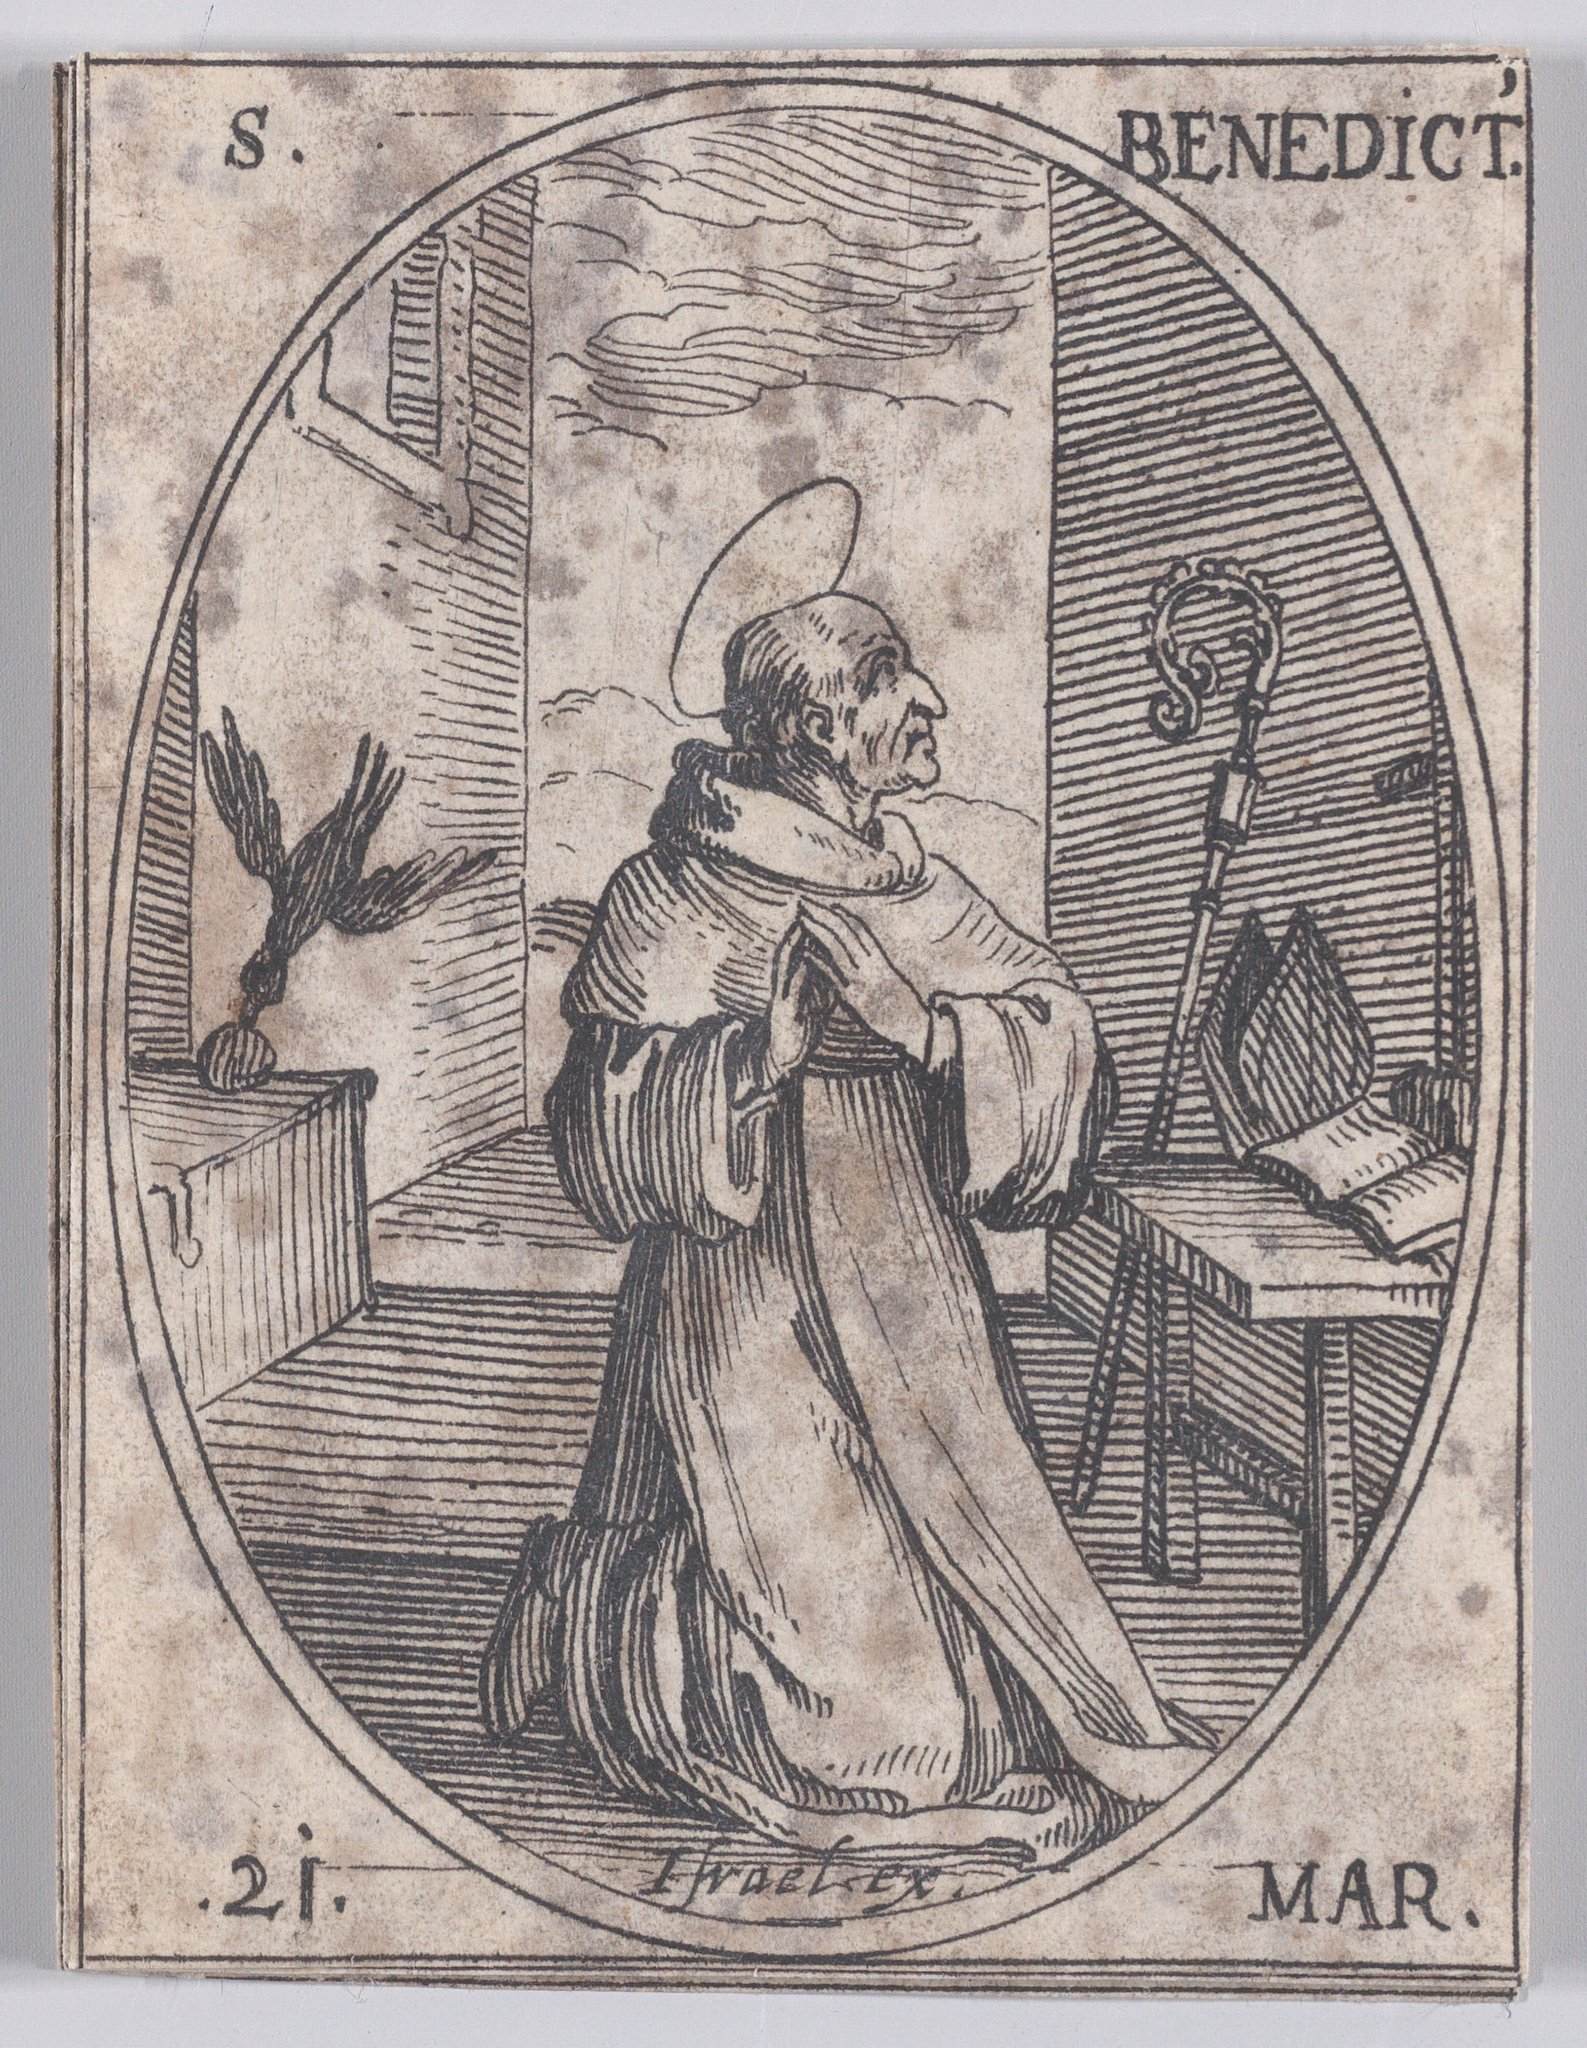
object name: print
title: S. Benoit (St. Benedict), March 21st, from "Les Images De Tous Les Saincts et Saintes de L'Année" (Images of All of the Saints and Religious Events of the Year)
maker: jacques callot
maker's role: artist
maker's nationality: french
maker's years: 1592-1635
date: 1636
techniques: etching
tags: men,saints